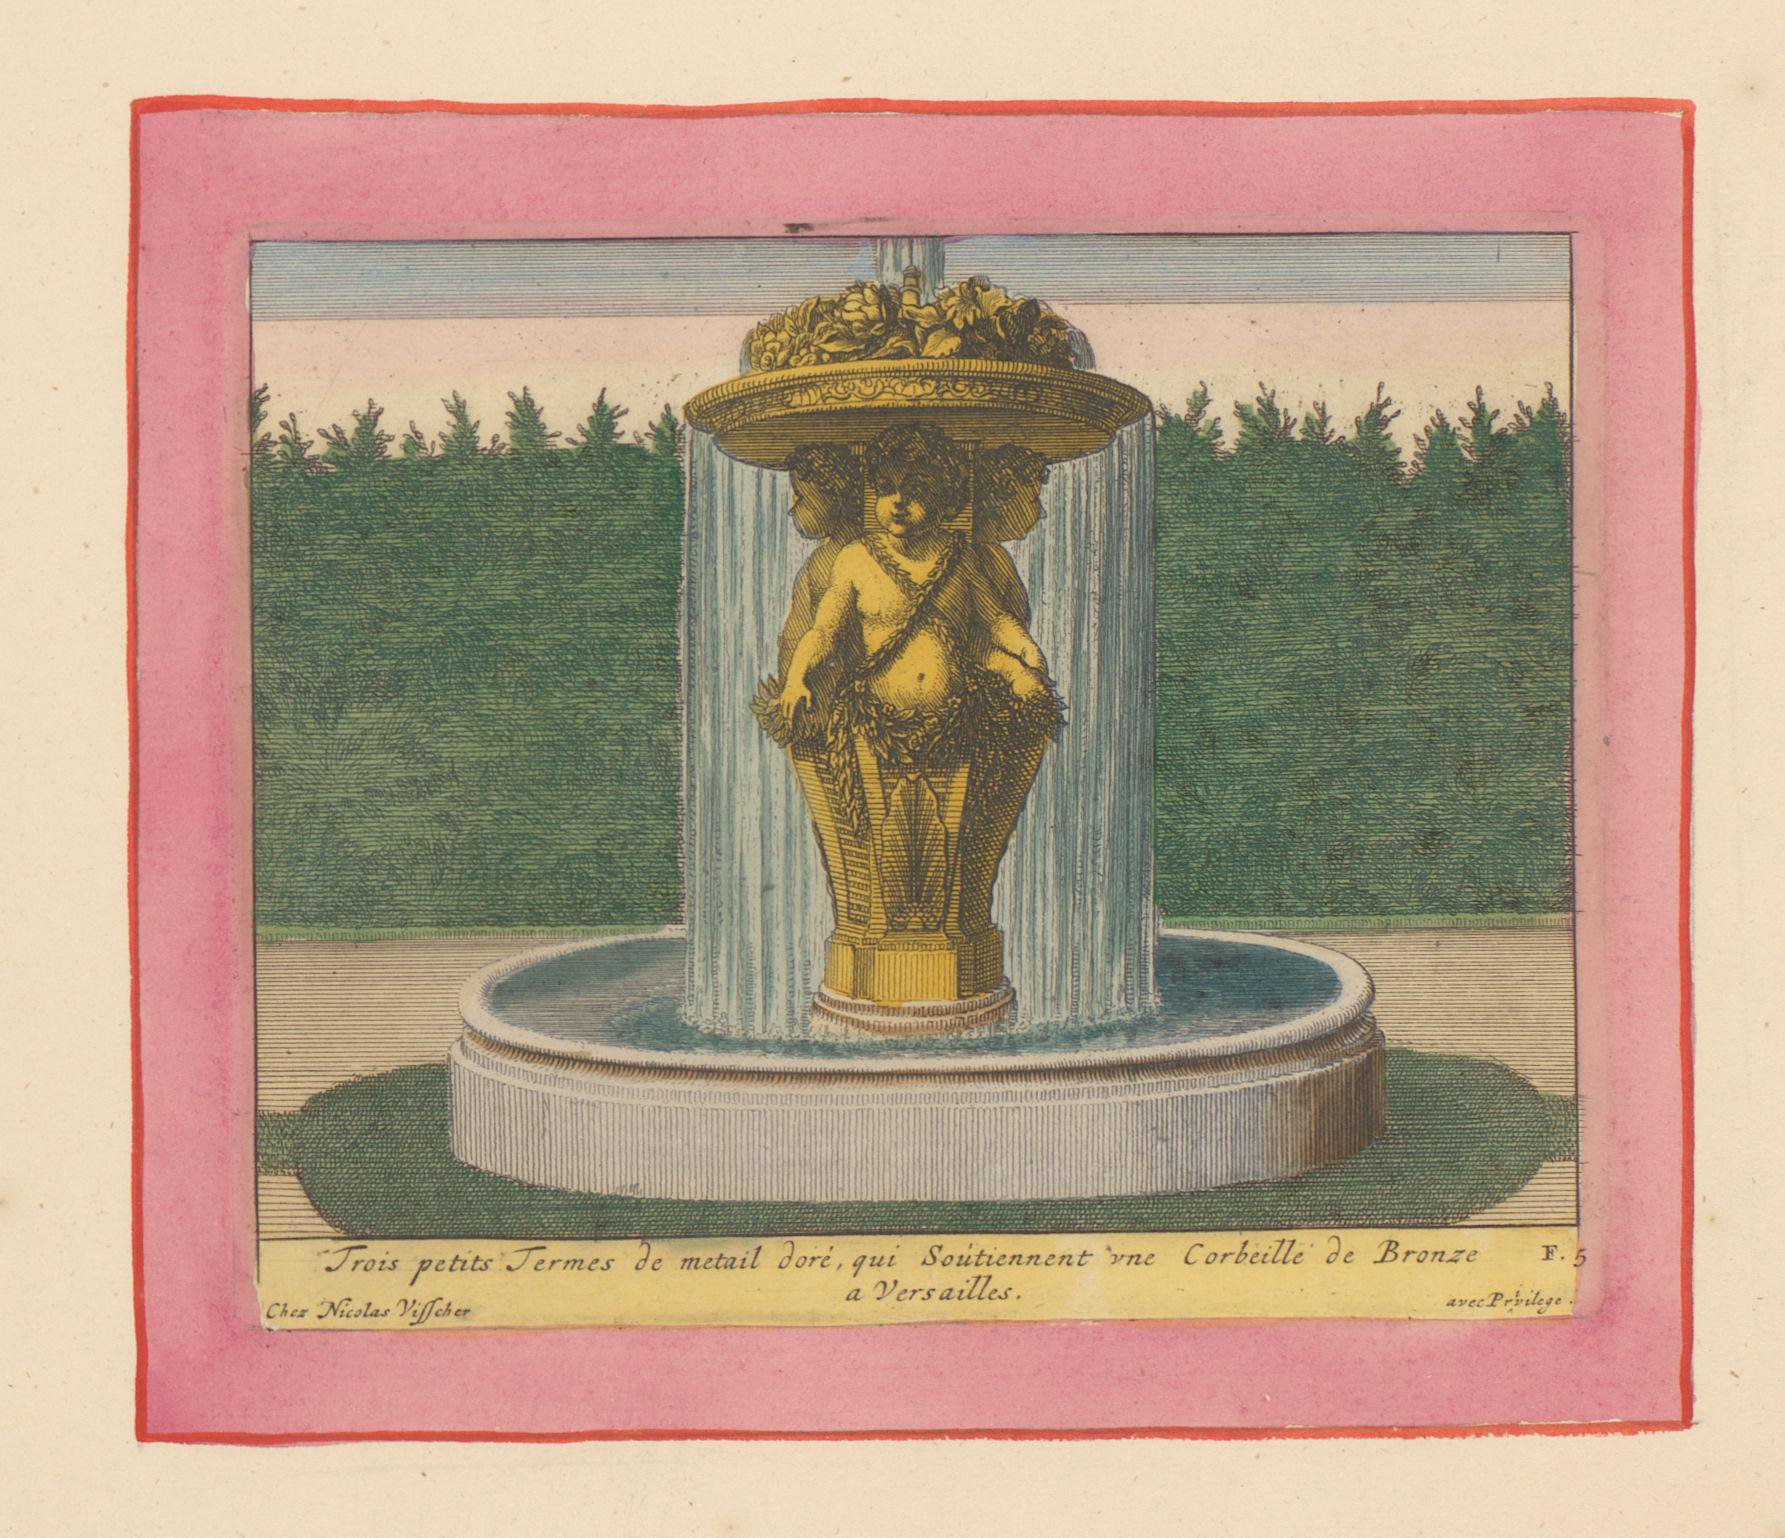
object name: print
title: Trois petits Termes de metail doré, qui Soûtiennent une Corbeille de Bronze a Versailles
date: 1686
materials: paper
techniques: etching, hand coloring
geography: amsterdam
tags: garden fountain, statues, sculptures in garden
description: Fontein met een beeld van drie termen van goudmetaal die een bronzen schaal boven hun hoofden dragen in de tuinen van Versailles. Rechtsonder het serienummer: F5. Prent maakt deel uit van een album.